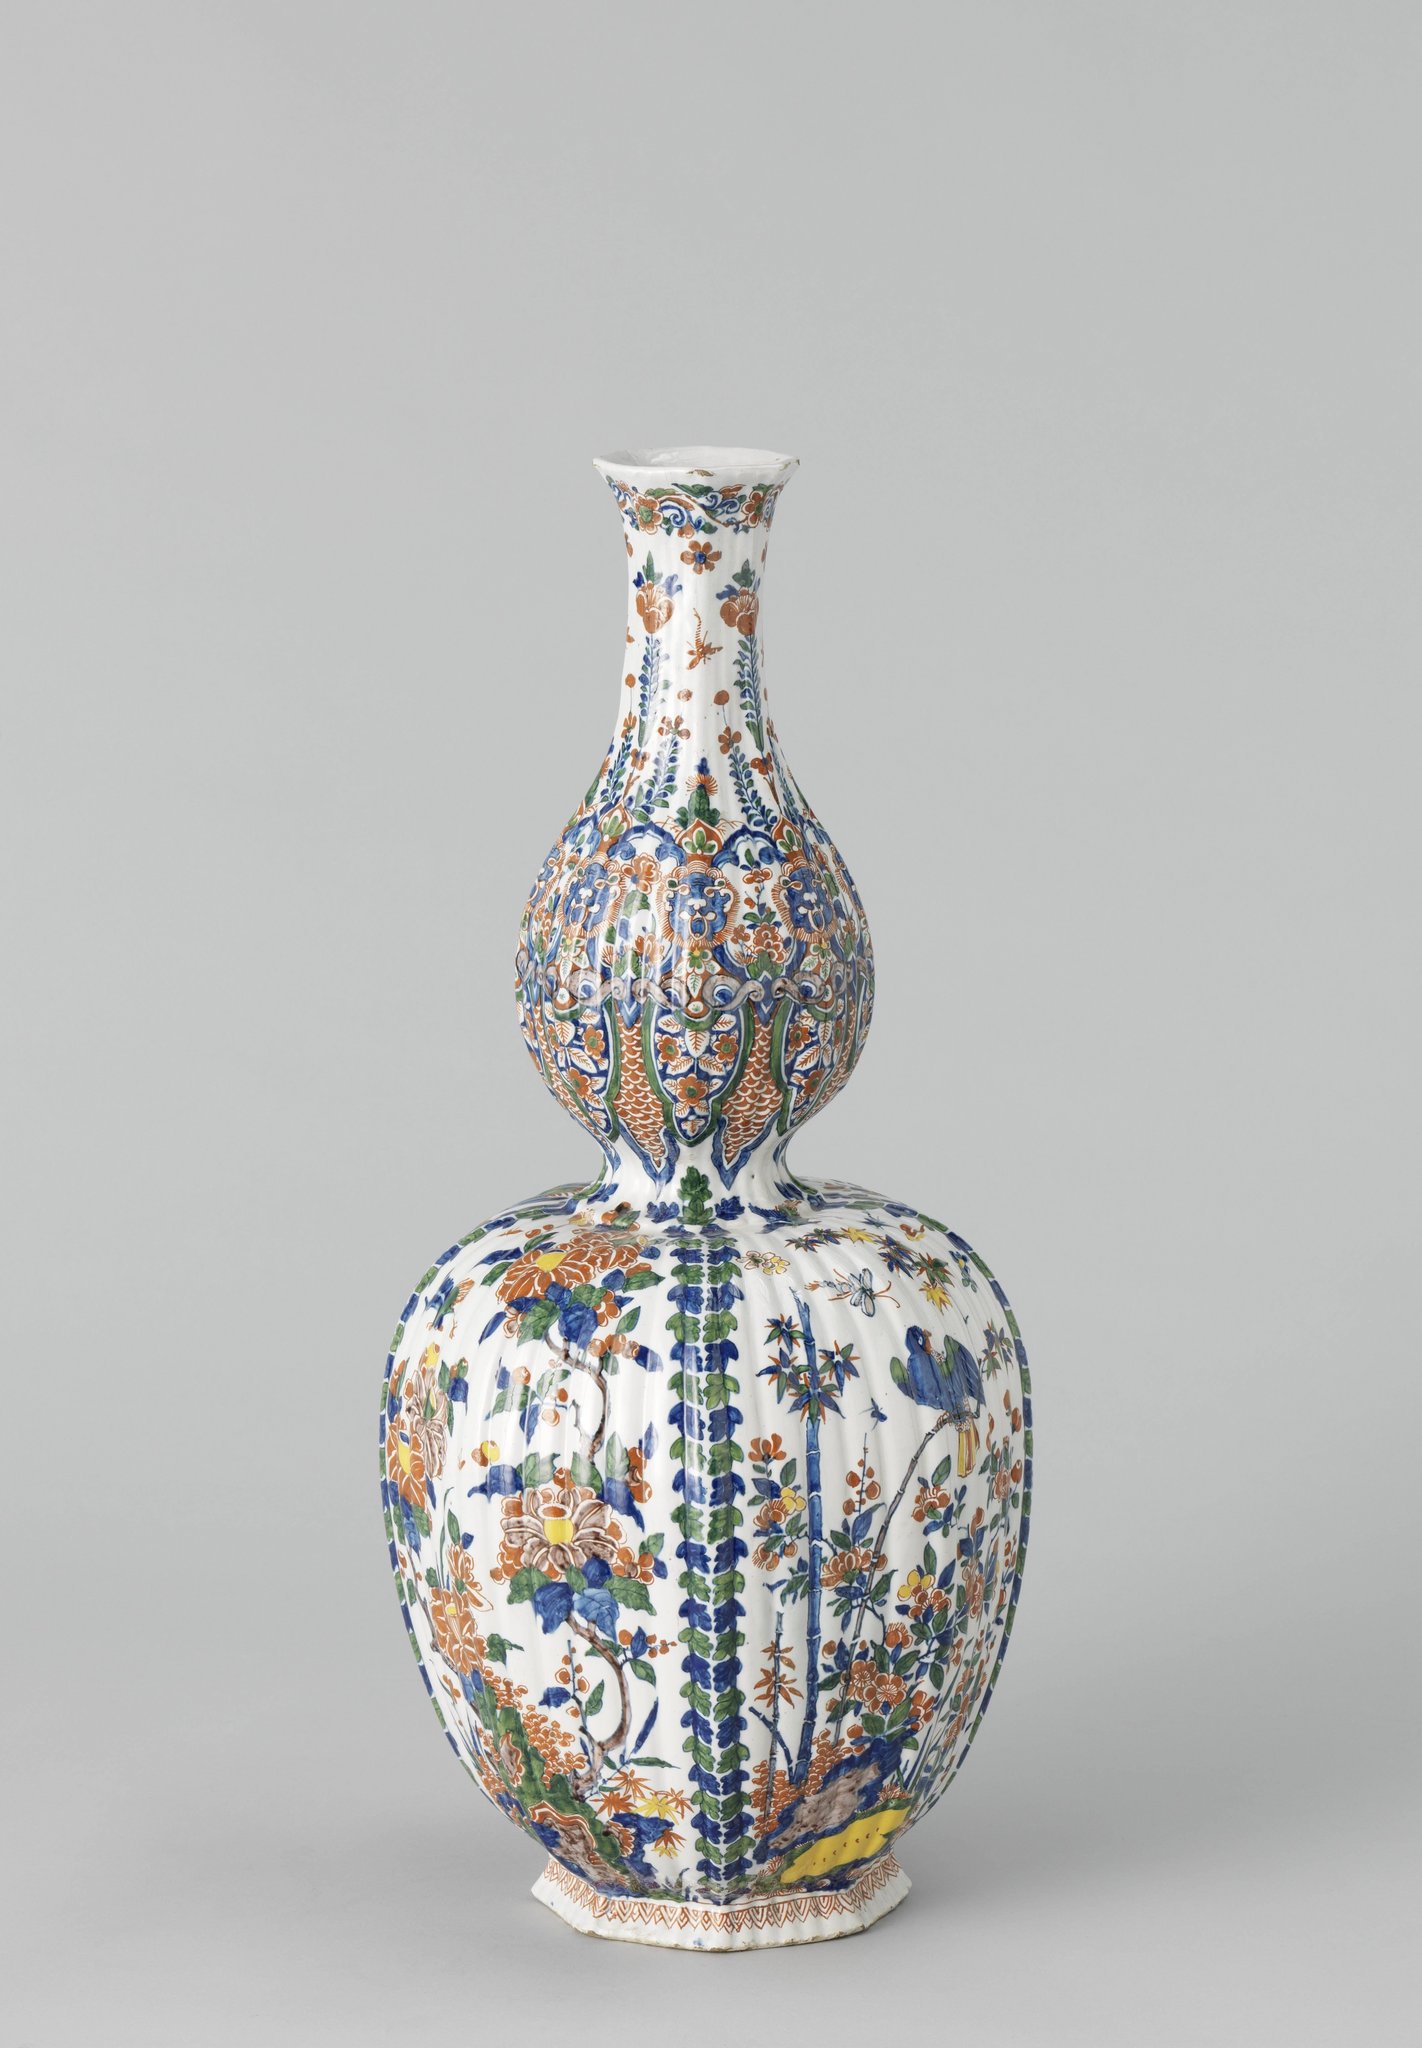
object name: kaststel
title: Fles van veelkleurig beschilderde faience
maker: Anonymous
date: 1695-1715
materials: earthenware, paint, glaze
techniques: firing, polychromy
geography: delft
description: Geribde, achthoekige veelkleurig beschilderde fles. Onderdeel van een kaststel bestaande uit vijf delen.